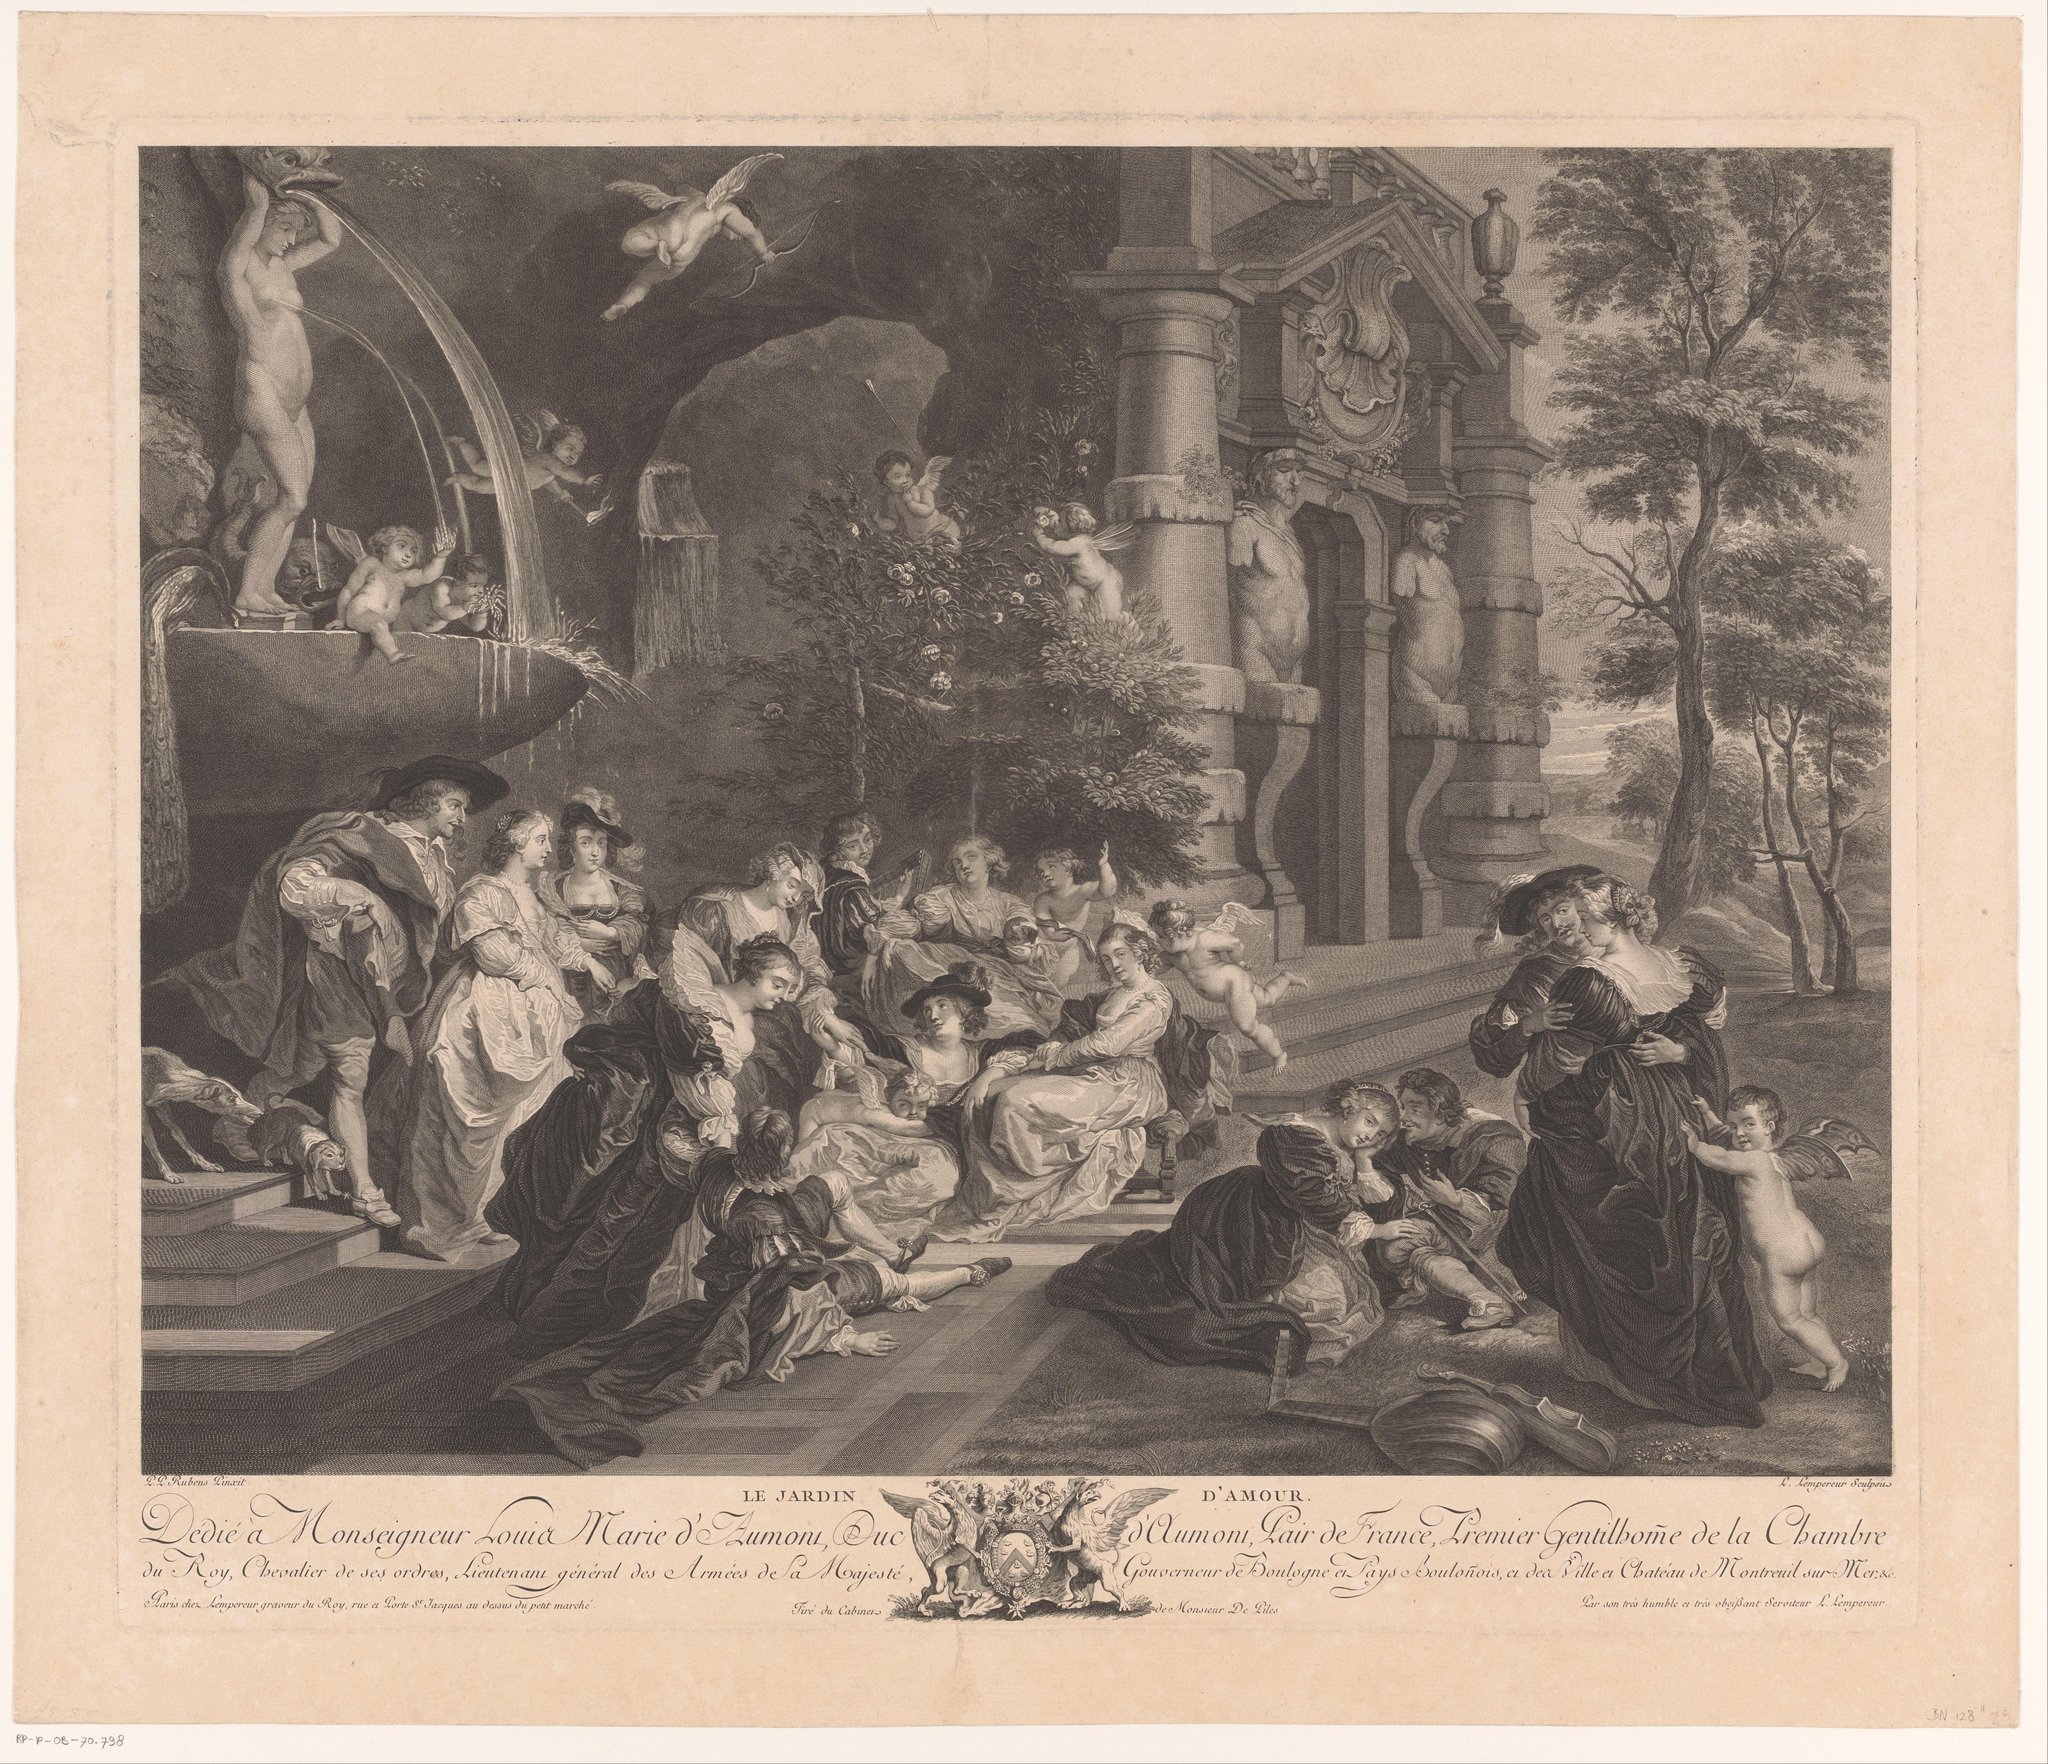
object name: print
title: Tuin der Liefde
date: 1769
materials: paper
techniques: engraving, etching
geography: paris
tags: garden fountain, garden of love, court of love, 'fête galante', cupids: 'amores', 'amoretti', 'putti'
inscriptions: collector's mark: Lugt 240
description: Het schilderij bevindt zich in de Gemäldegalerie Alte Meister te Dresden, inv.nr. 976.